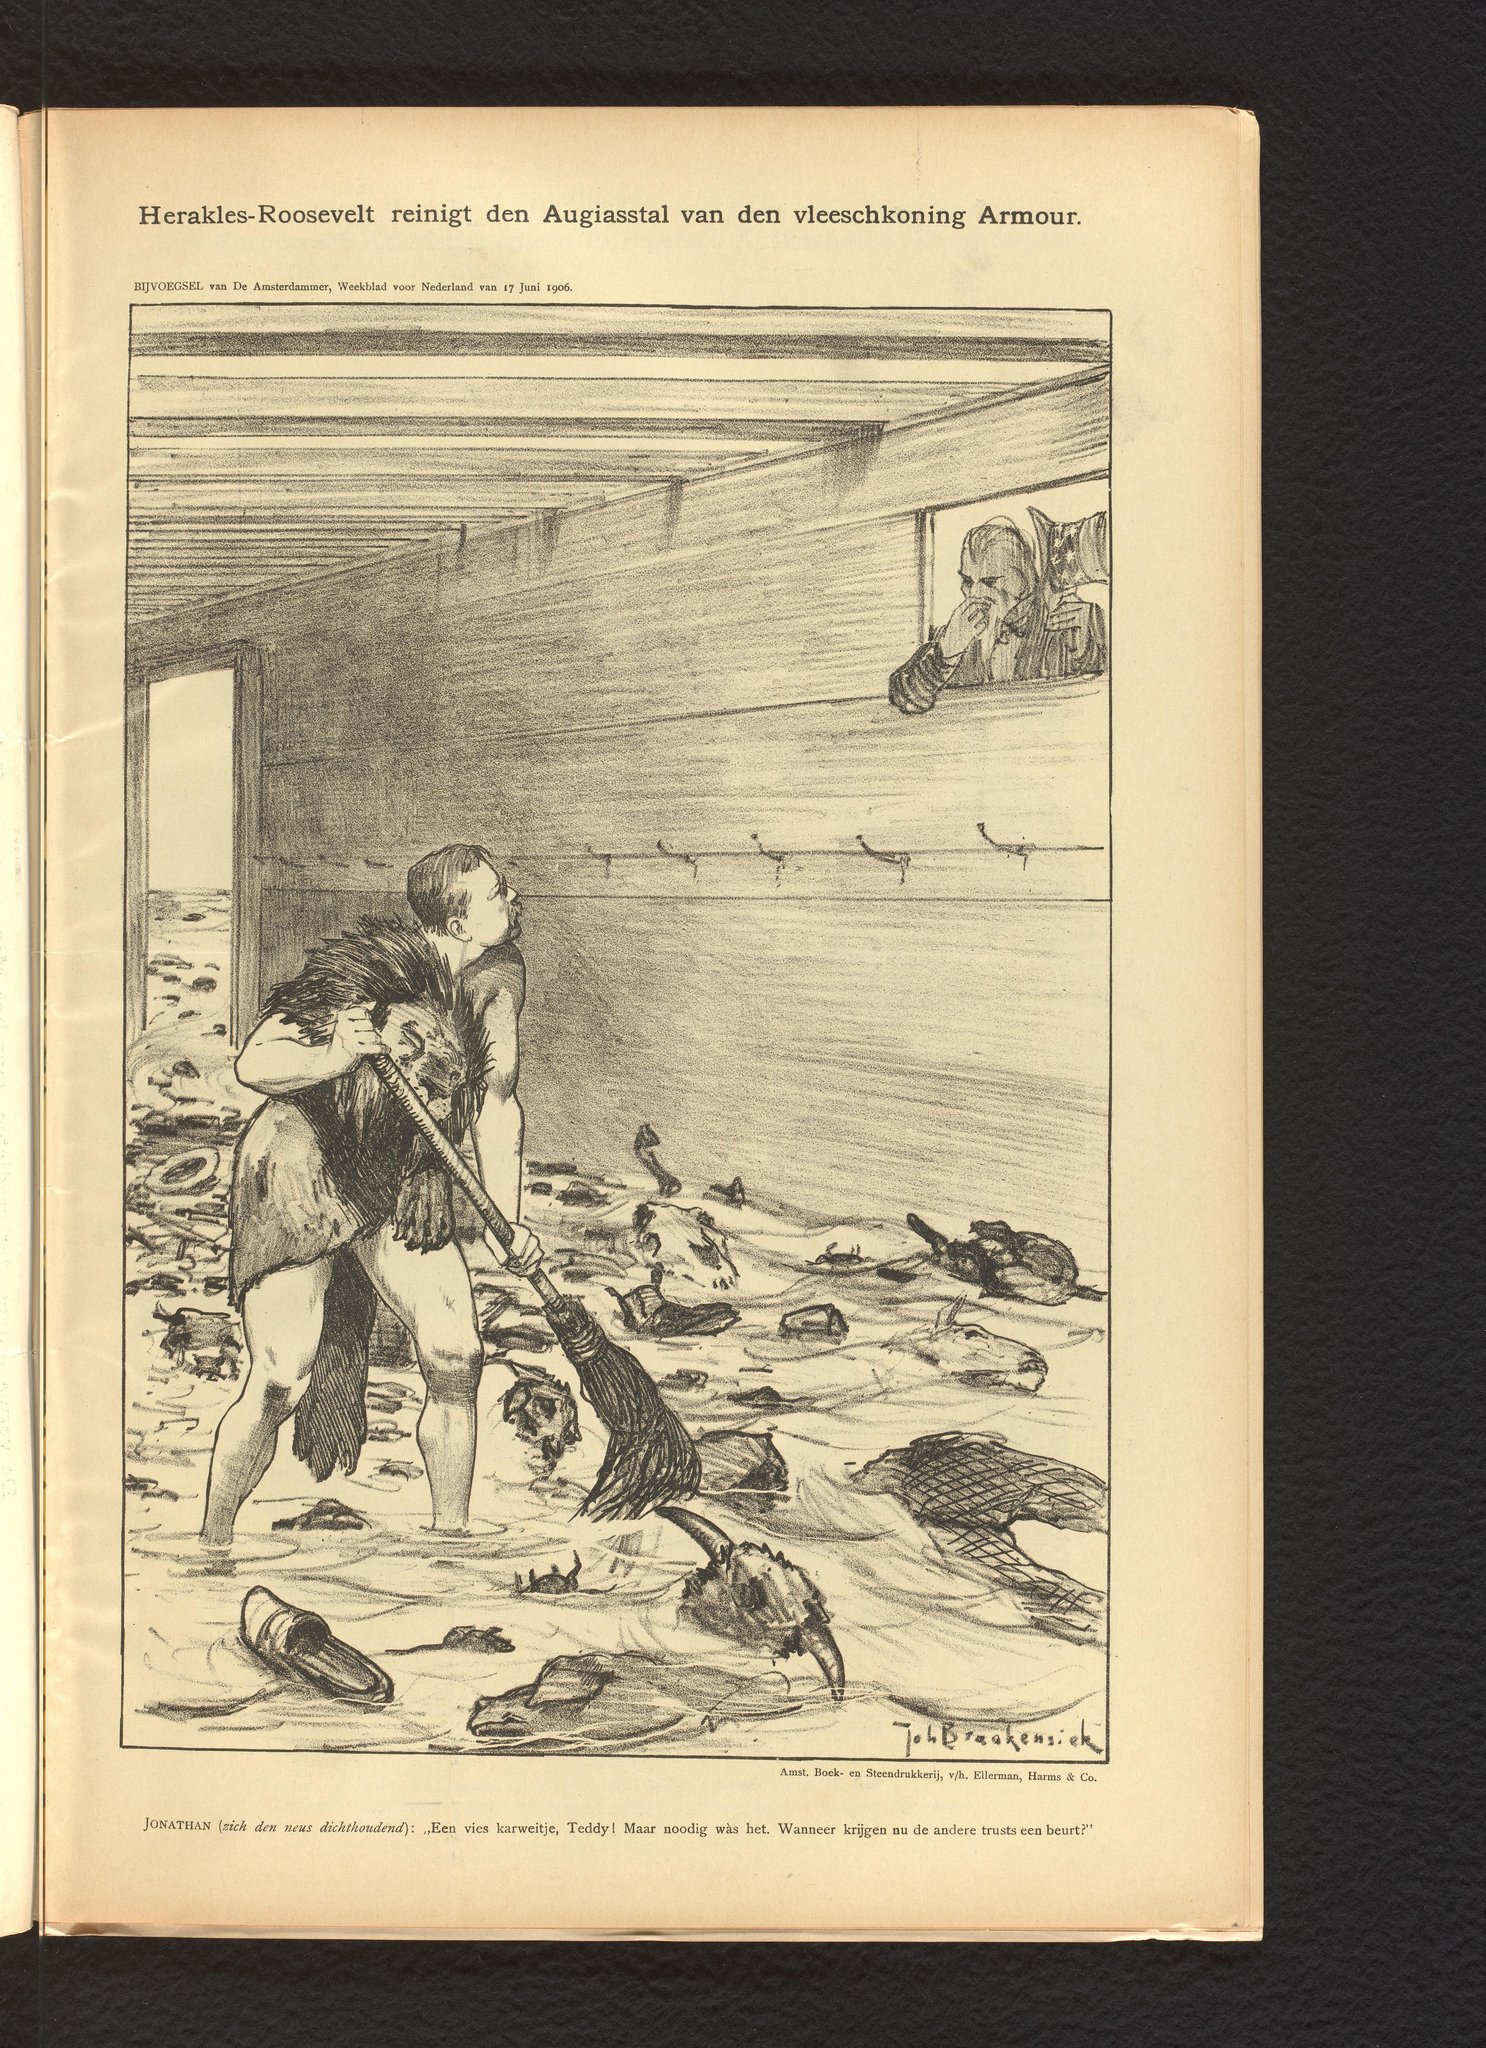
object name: cartoon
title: Herakles-Roosevelt reinigt den Augiasstal van den vleeschkoning Armour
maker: johan braakensiek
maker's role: draughtsman, print maker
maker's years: 1858-1940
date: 1906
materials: paper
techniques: lithograph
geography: amsterdam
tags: new york (city), personifications of countries, nations, states, districts, etc., (5) hercules cleanses the stables of augeas by diverting the rivers alpheus and peneus, trust, cartel, monopoly, political caricatures and satires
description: De Amerikaanse president Teddy Roosevelt in zijn strijd tegen Amerikaanse trusts en kartels maakt als Hercules de Augiasstal van de vleesverwerkingsbedrijf Armour & Company schoon. Uncle Sam (Verenigde Staten), hier Jonathan genaamd, kijkt door een raampje naar binnen.